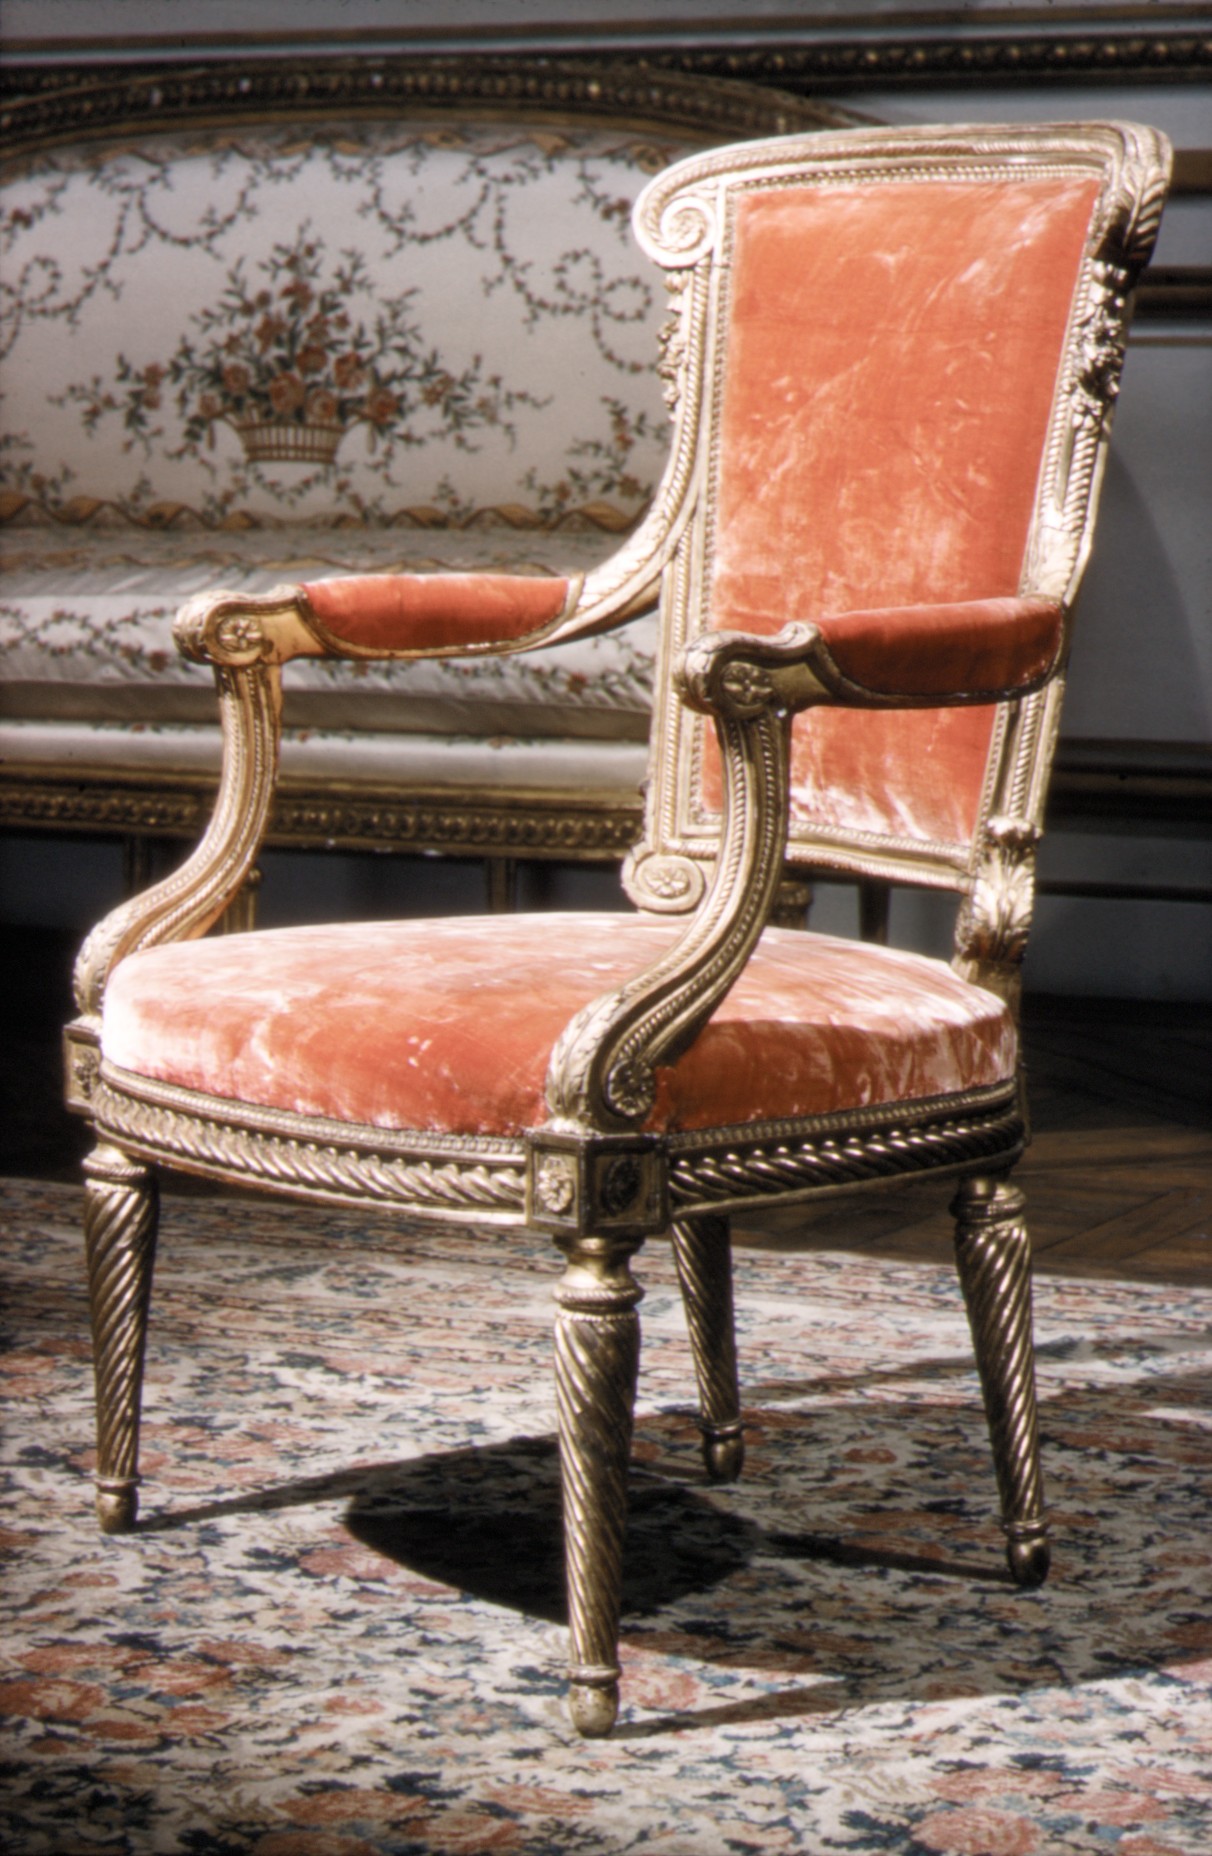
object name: armchair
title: Armchair (part of a set)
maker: georges jacob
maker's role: maker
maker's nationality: french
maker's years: 1739-1814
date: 1780-1790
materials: wood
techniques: gilding